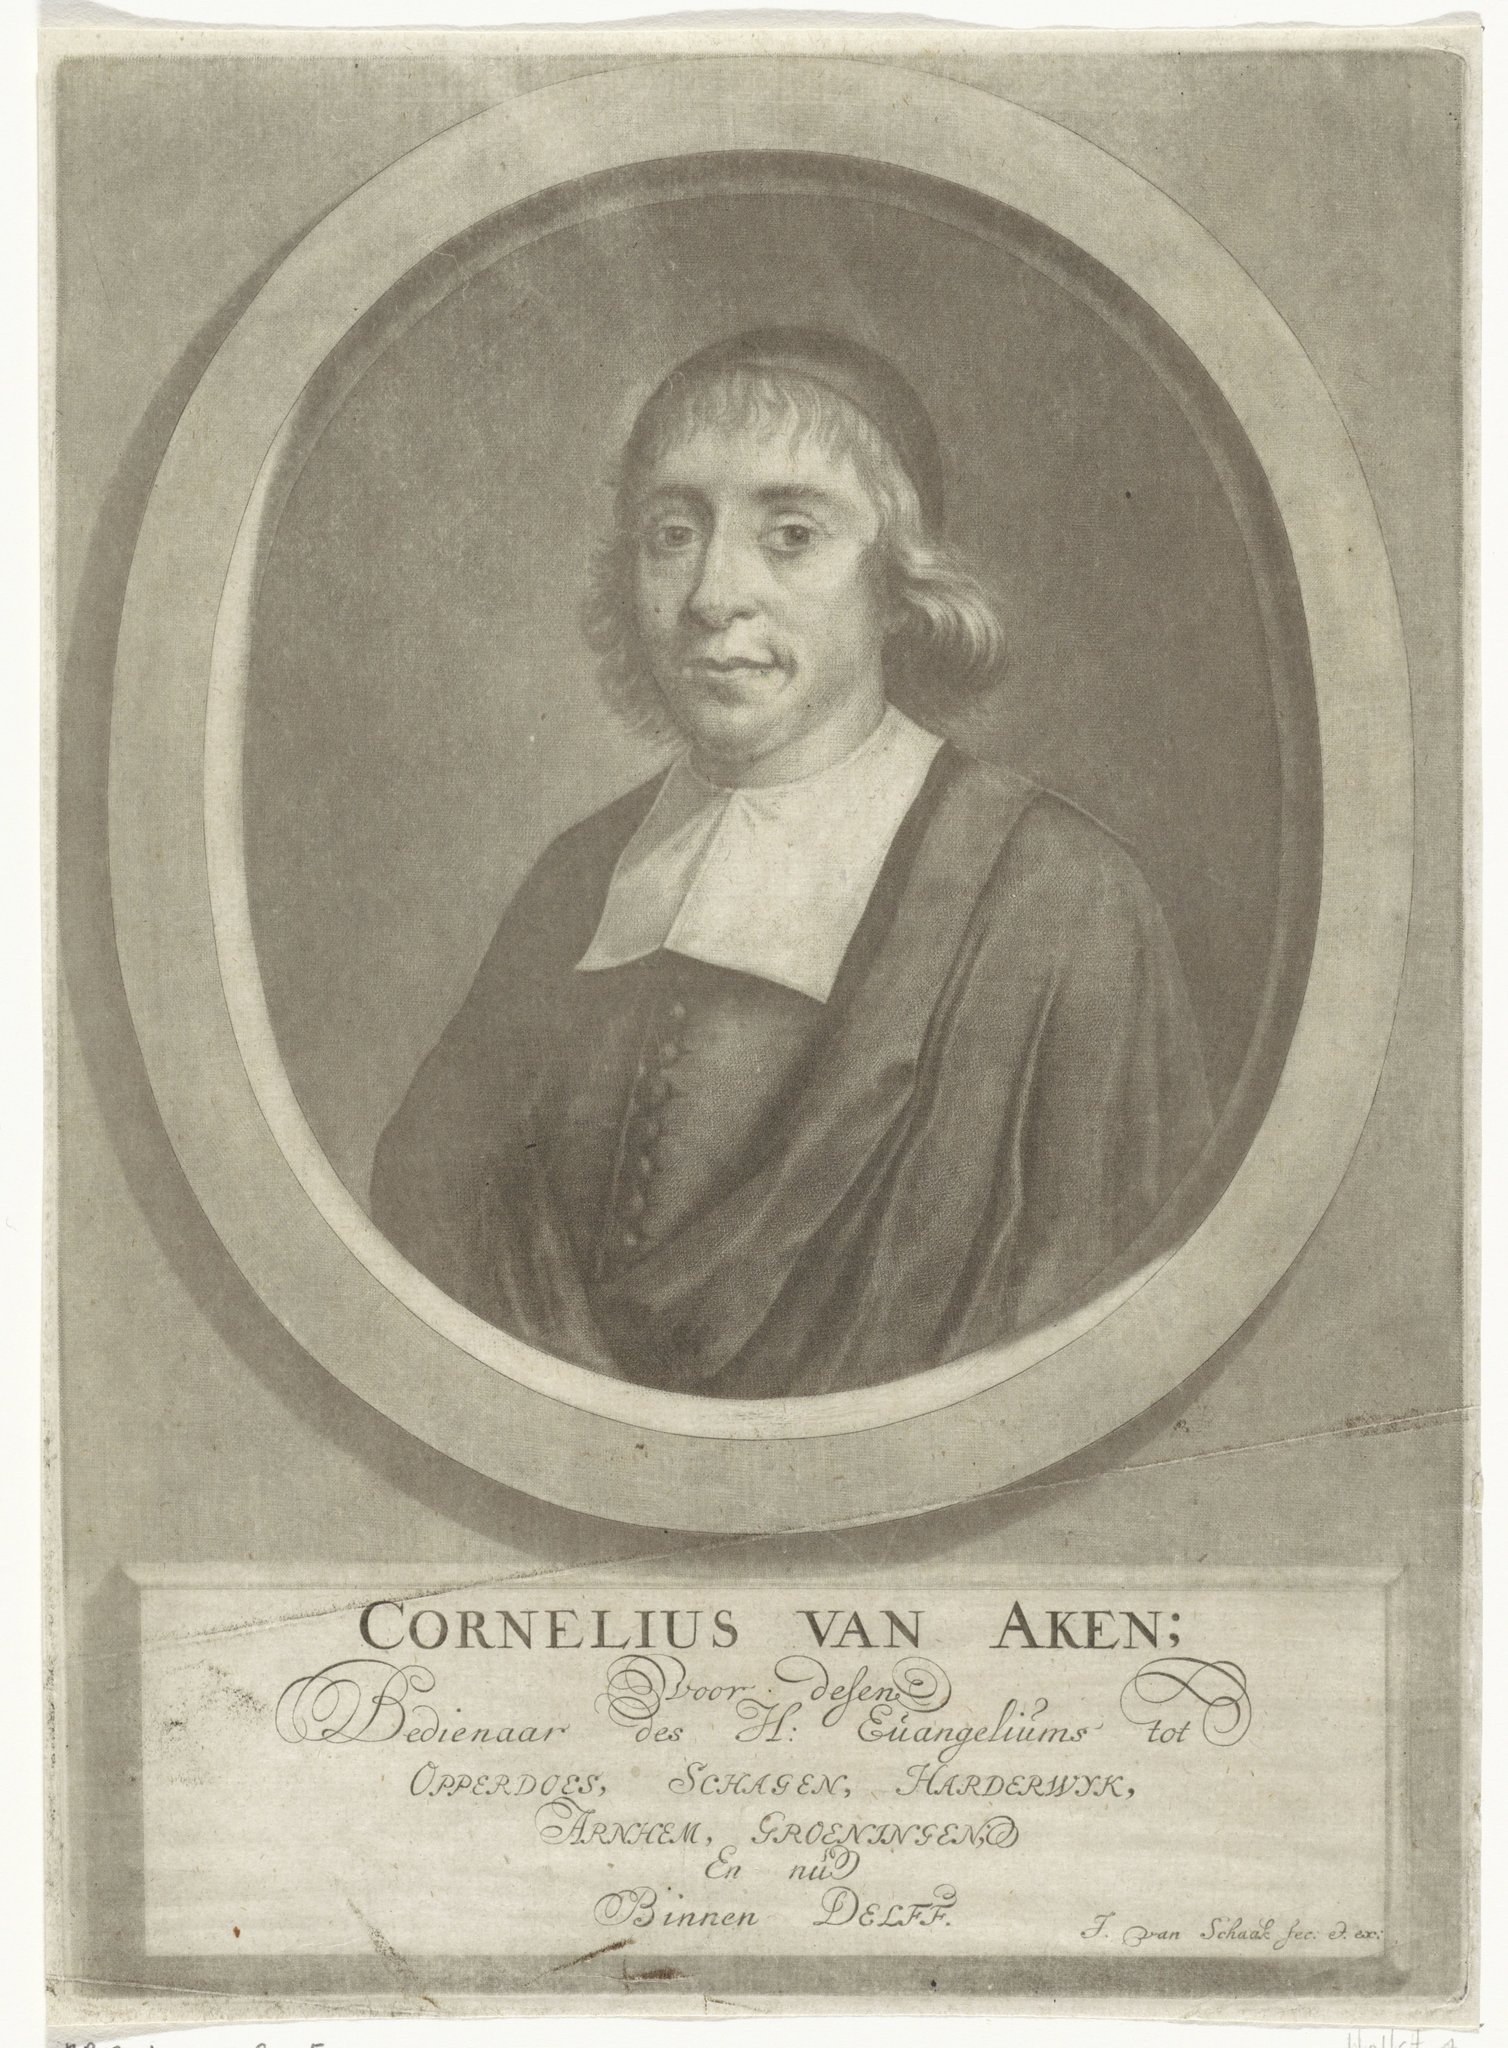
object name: print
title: Portret van de predikant Cornelius van Aken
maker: jeremias van schaak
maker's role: print maker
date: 1690-1727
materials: paper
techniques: engraving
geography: delft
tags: cornelius van aken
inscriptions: collector's mark: Lugt 2228